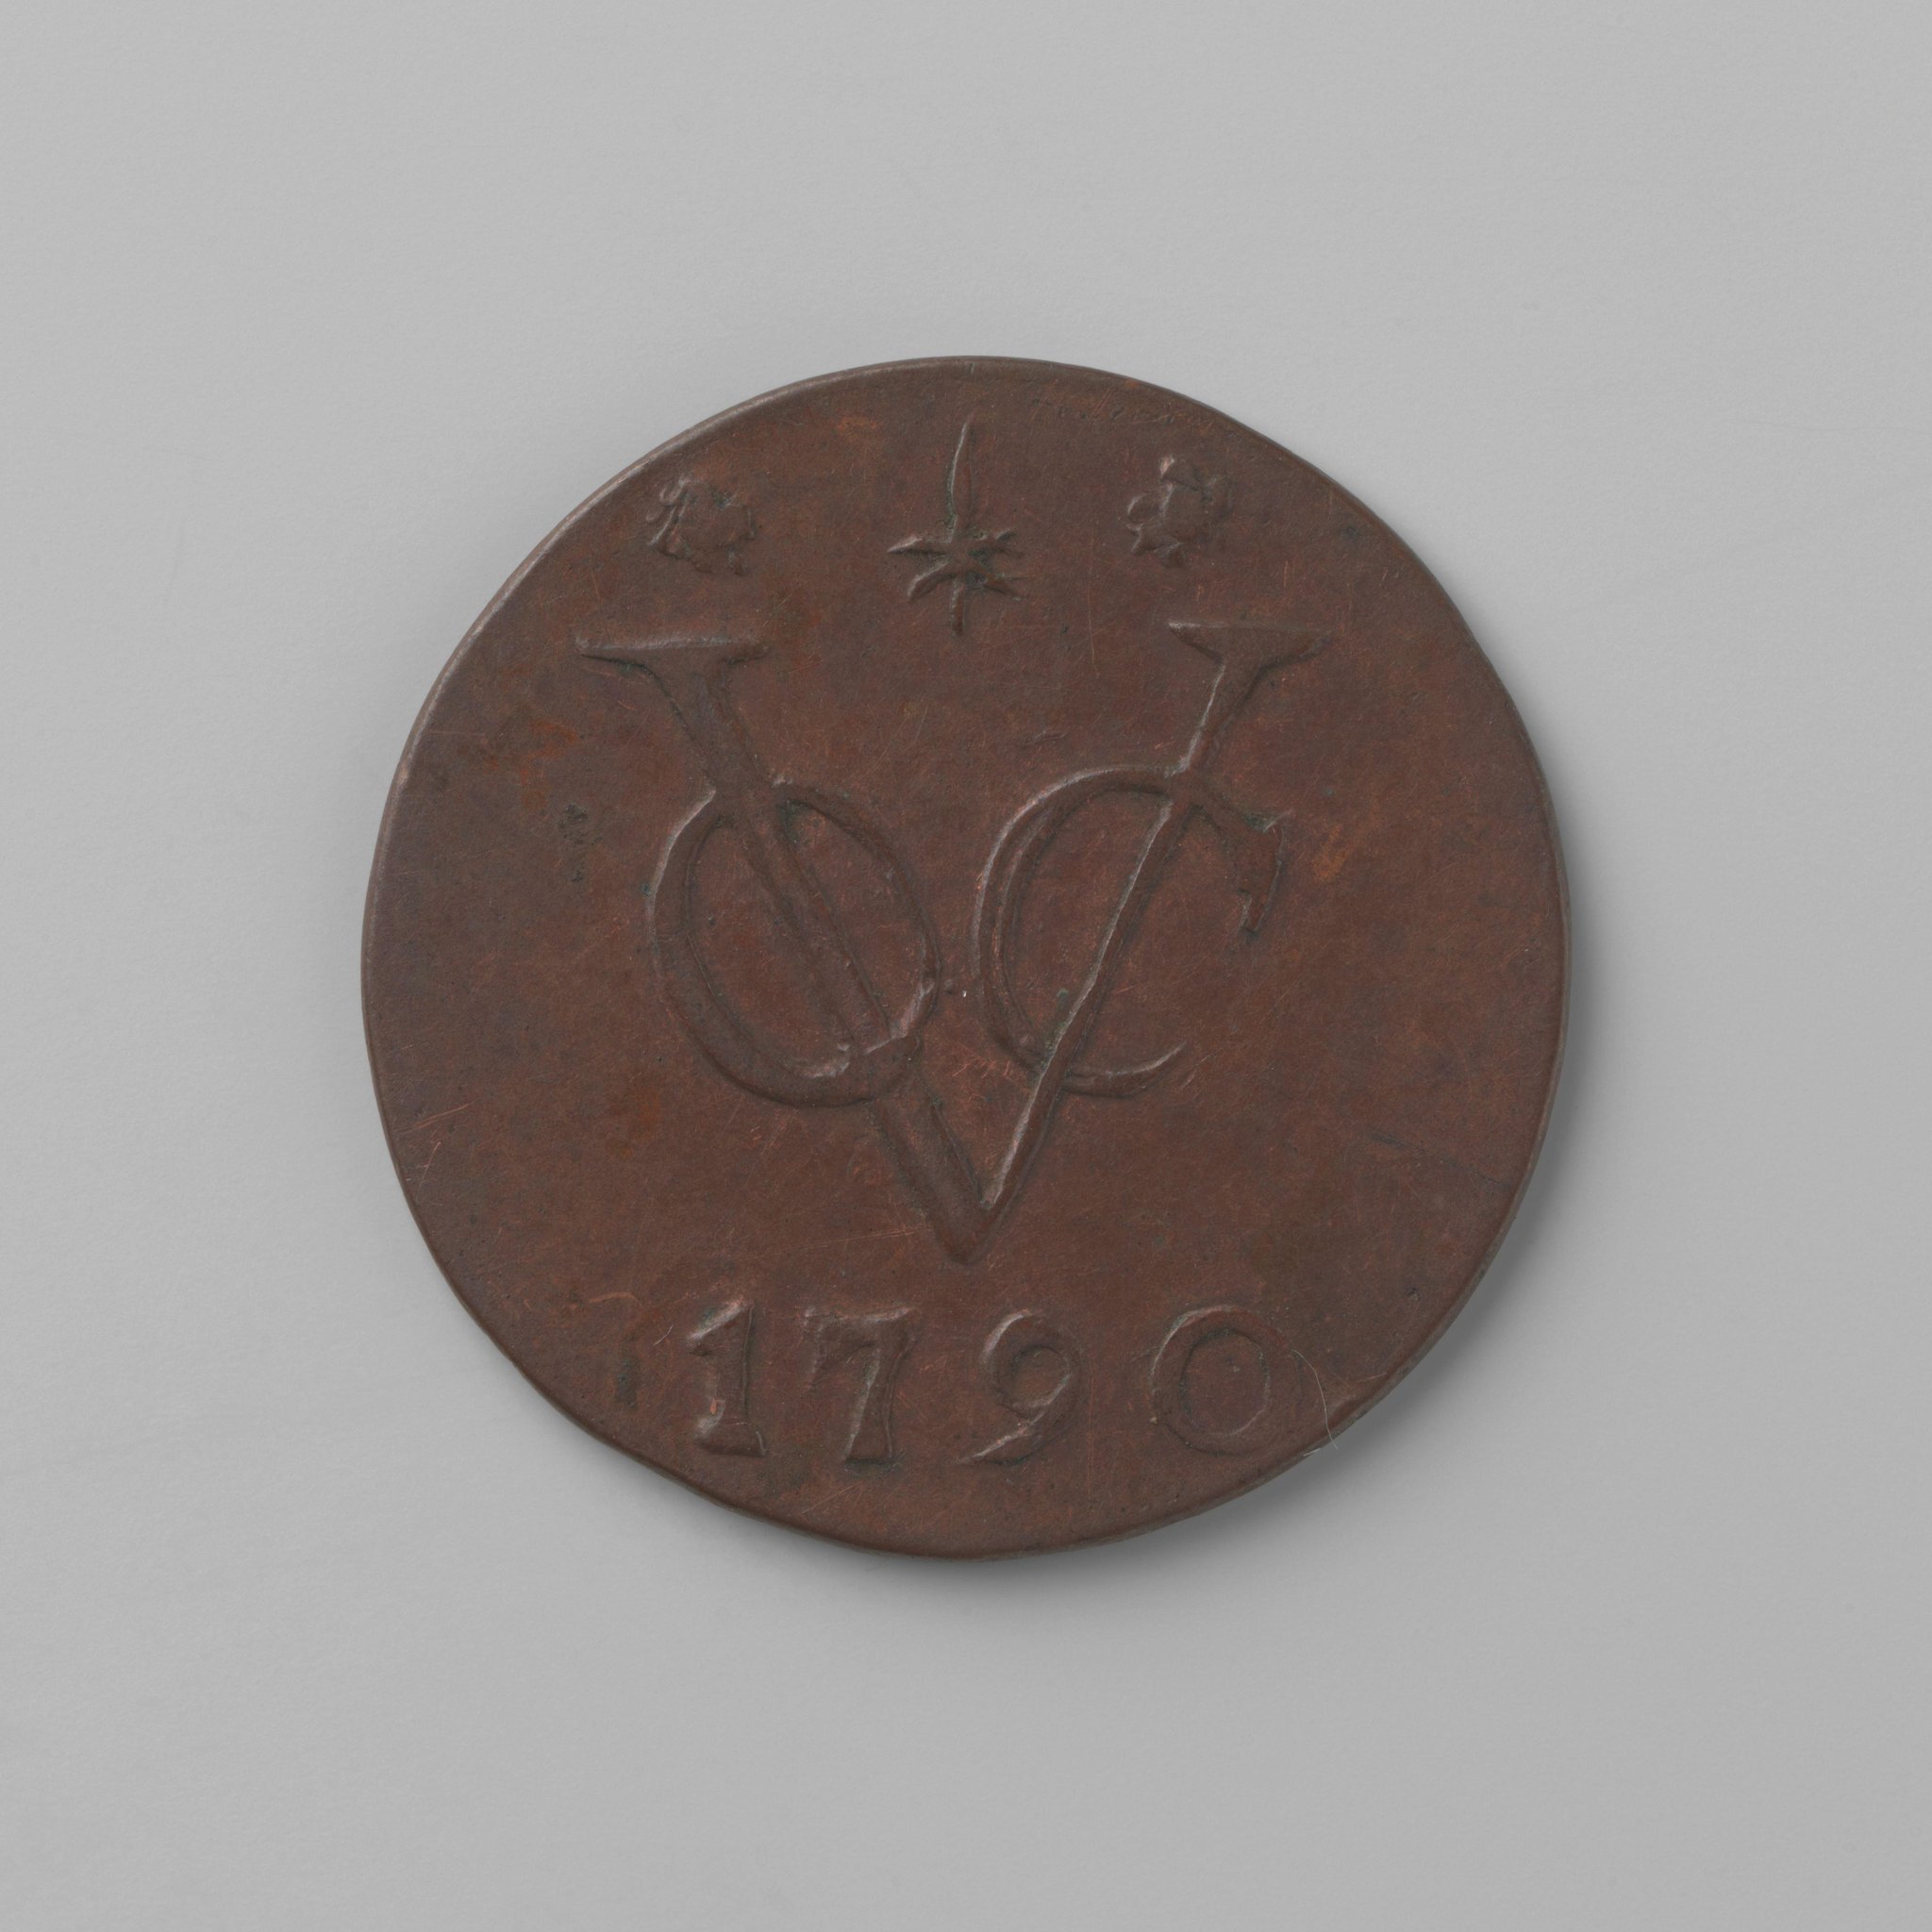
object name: coin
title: VOC, duit Gelderland,1790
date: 1790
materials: copper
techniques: striking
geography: harderwijk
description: Koperen munt. Voorzijde: tussen wapenspreuk gekroond wapenschild van Gelderland. Keerzijde: monogram van de VOC, waarboven muntmeesterteken en waaronder jaartal. Gladde rand.